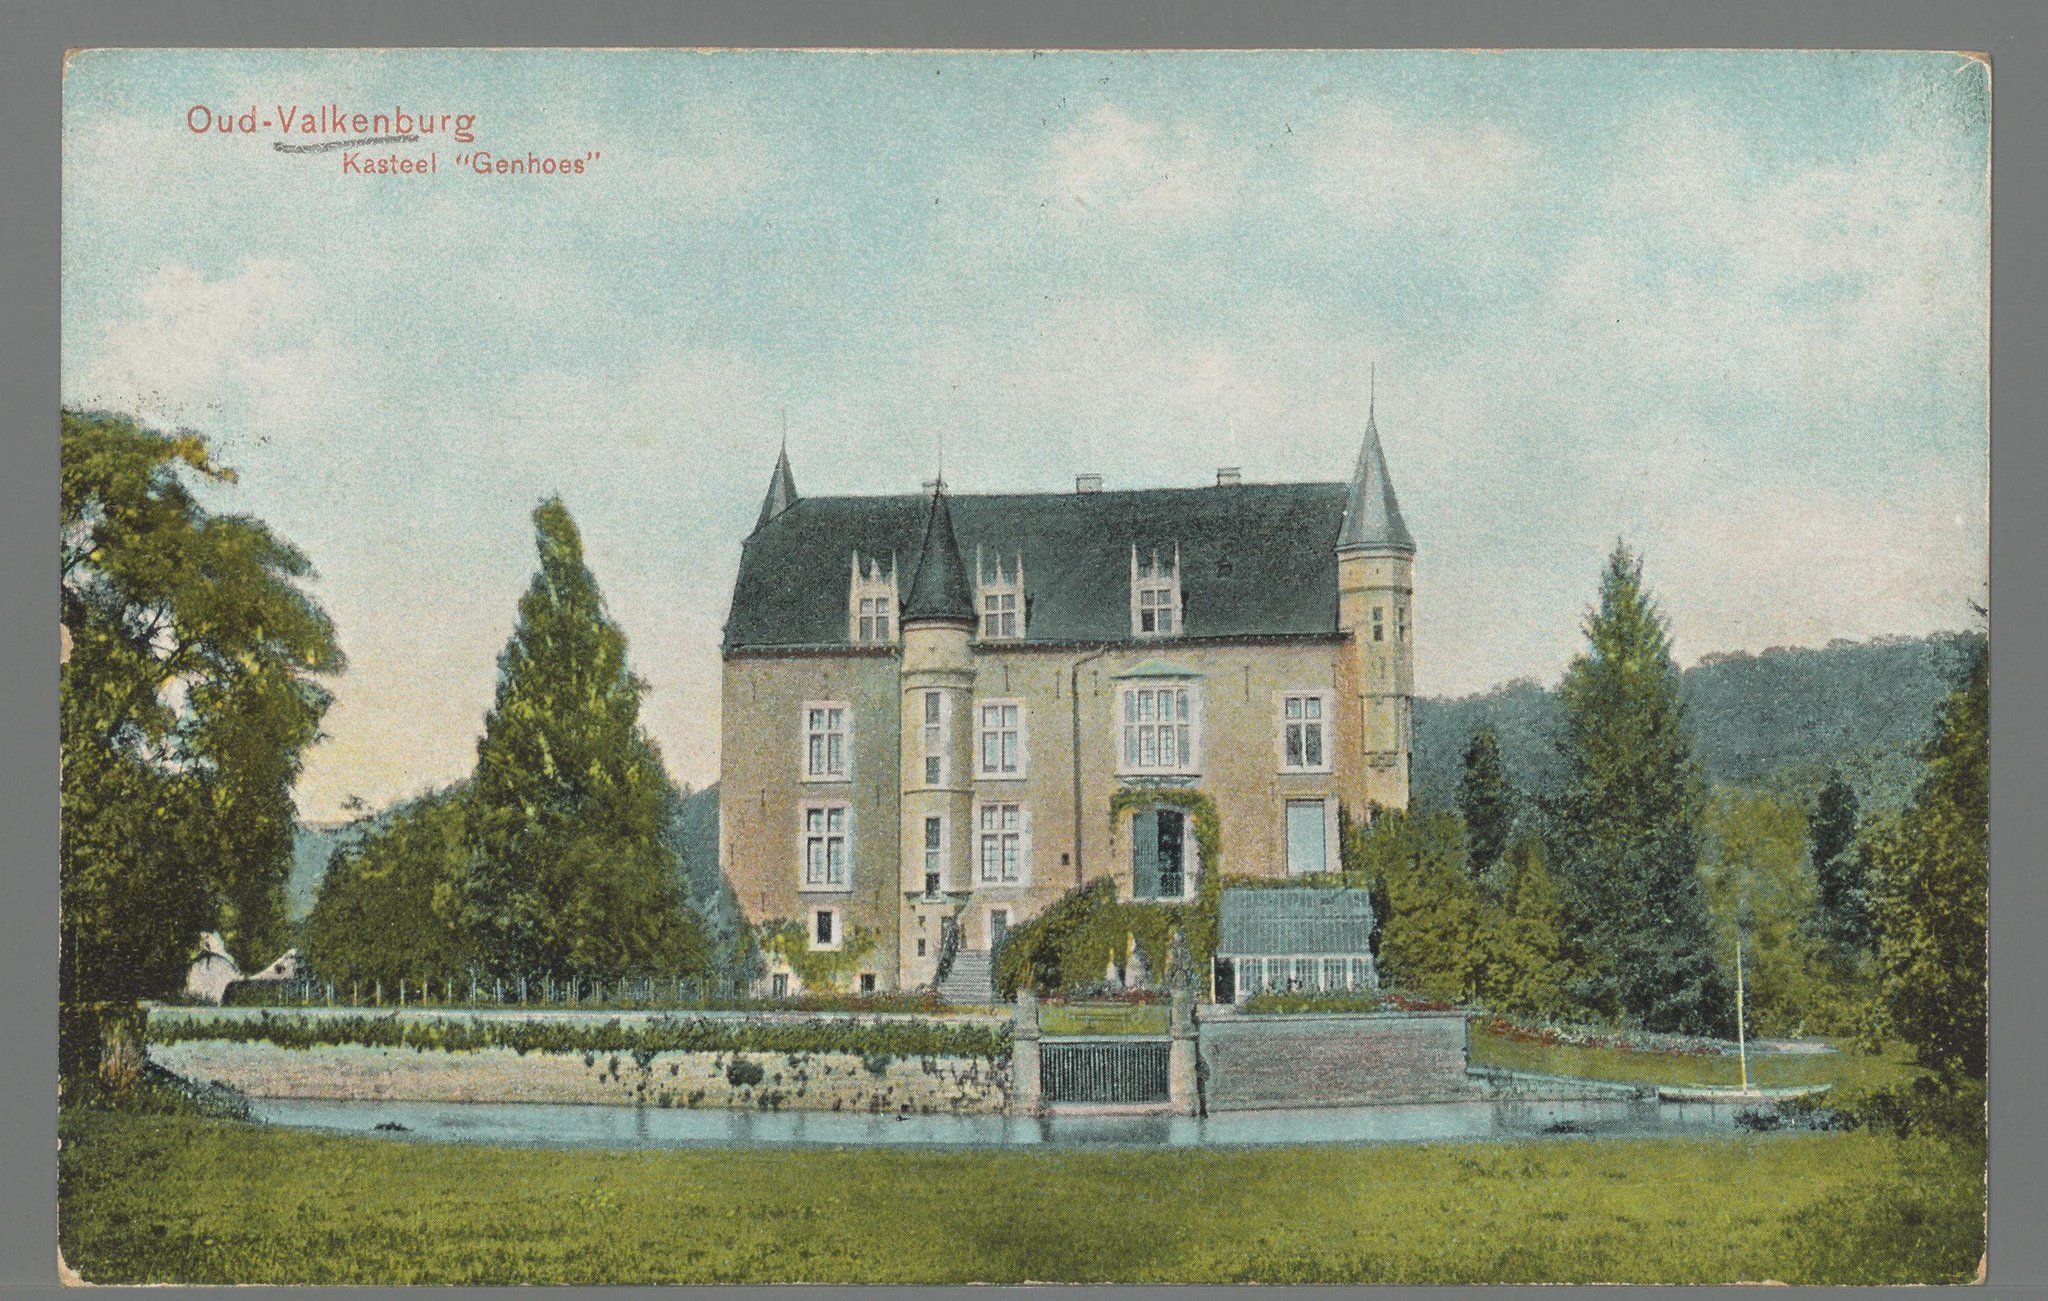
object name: photomechanical print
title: Oud-Valkenburg. Kasteel "Genhoes"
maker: Anonymous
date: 1906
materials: cardboard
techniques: lithograph, writing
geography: leipzig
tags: castle, canal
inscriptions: postage stamp